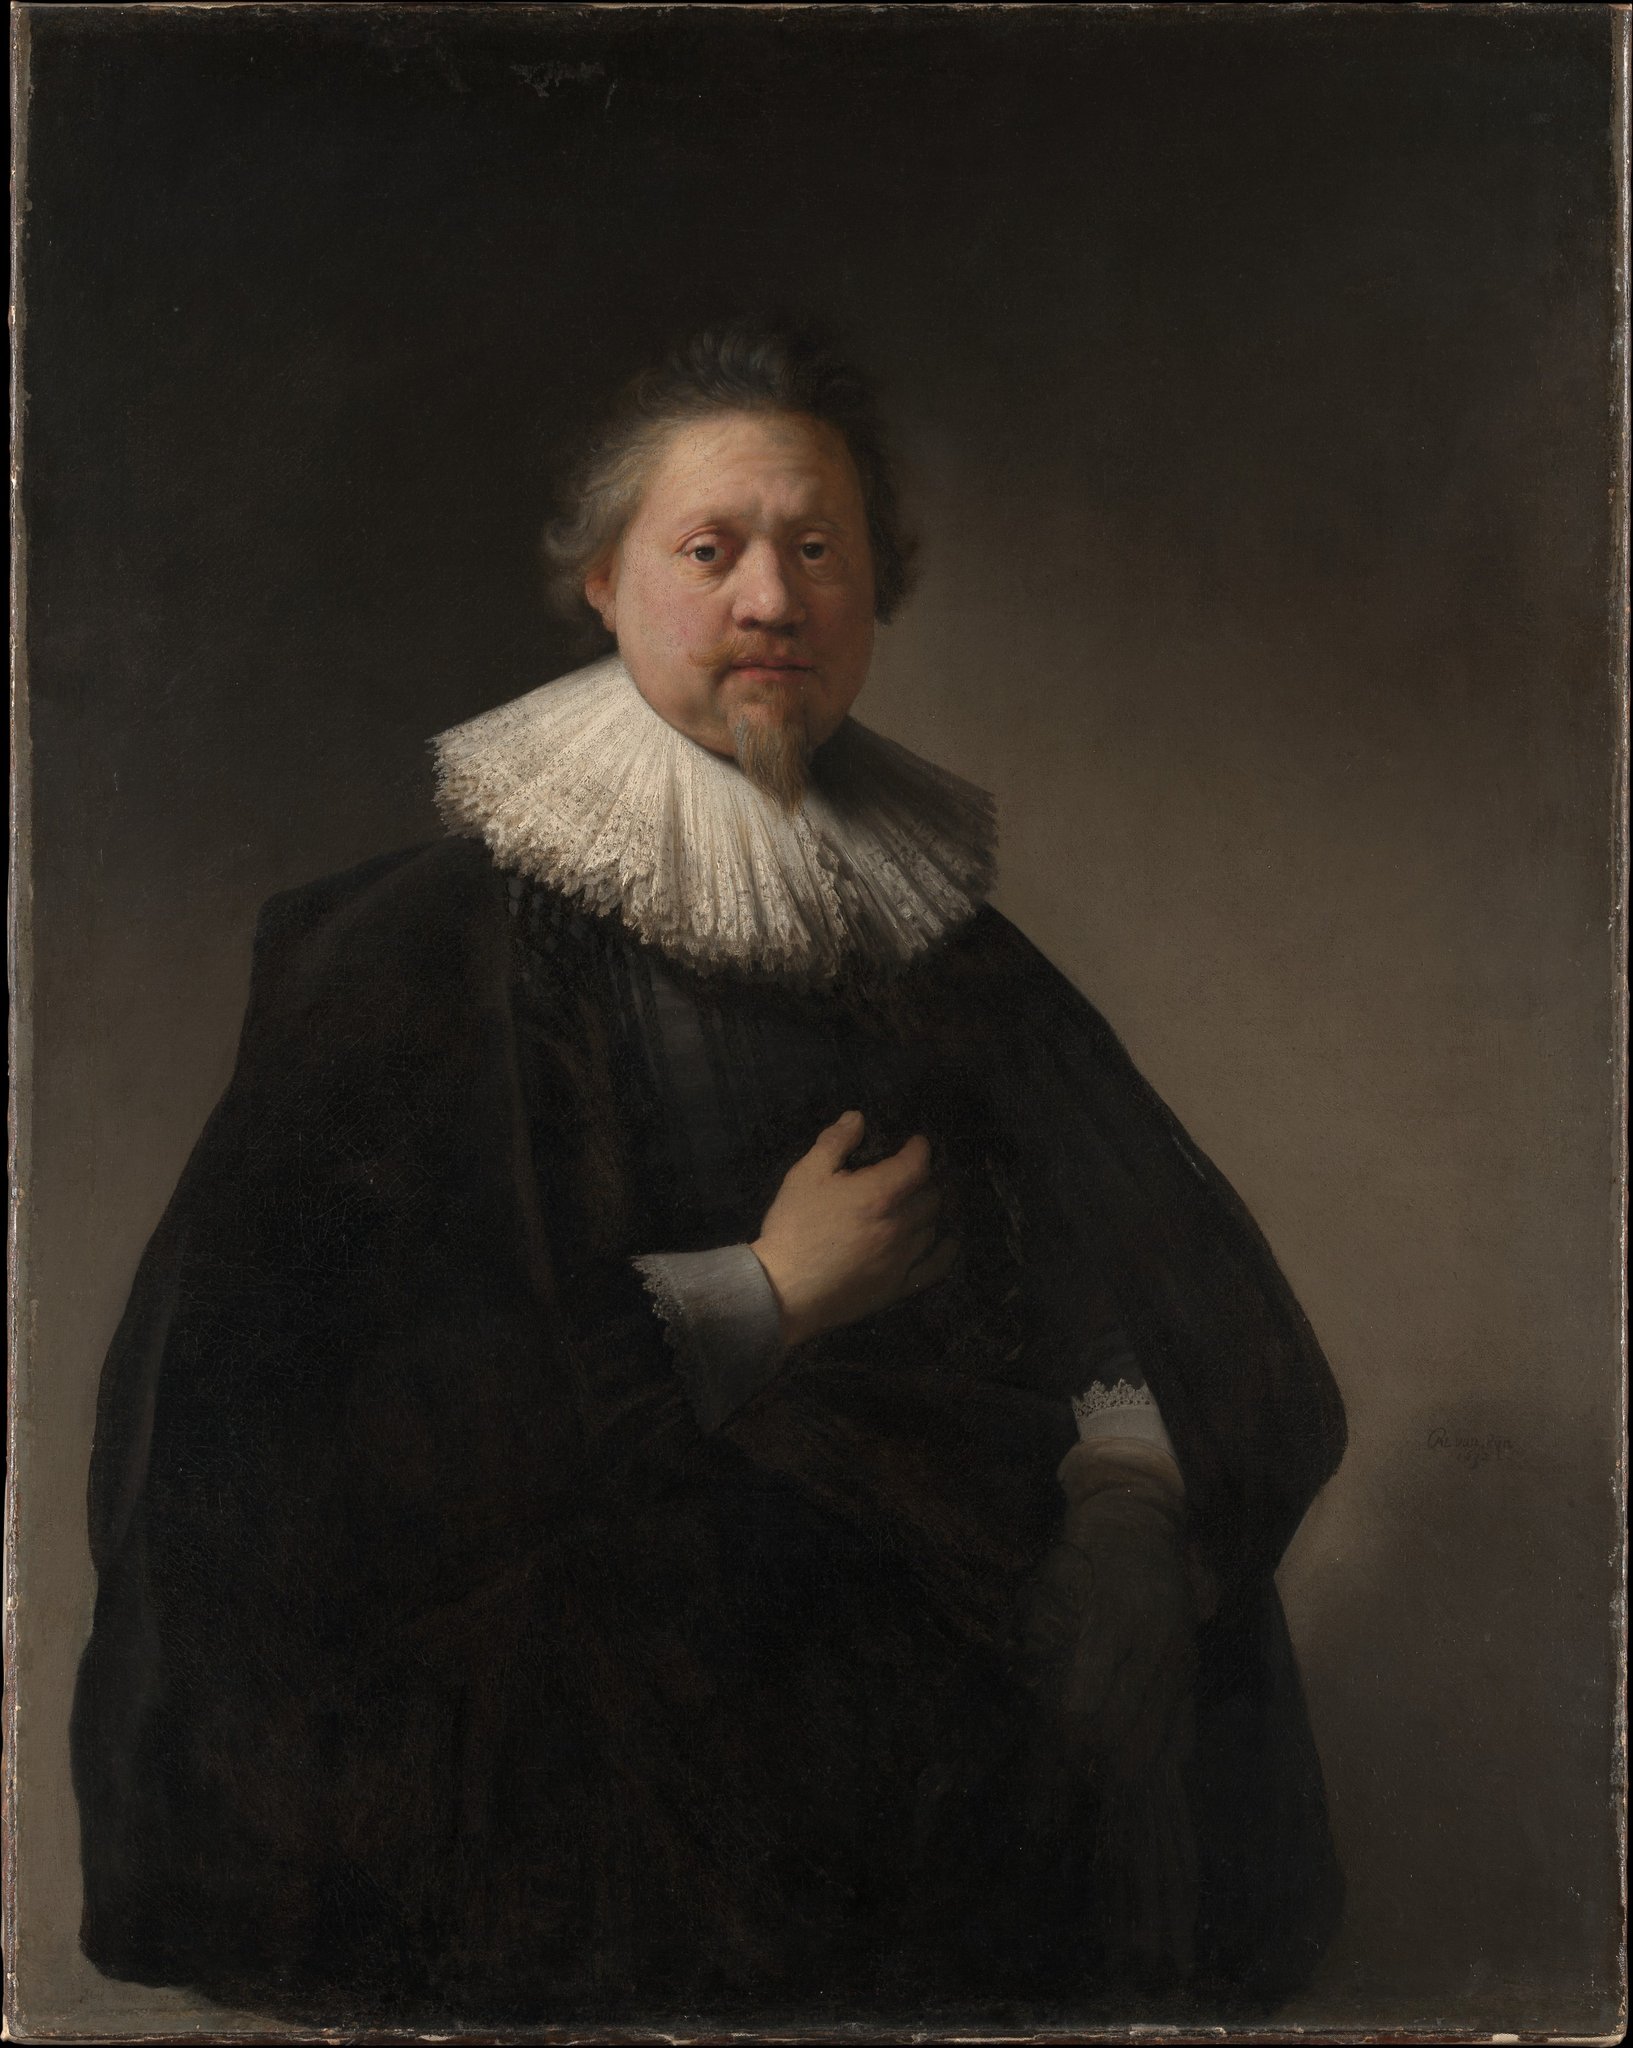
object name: painting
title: Portrait of a Man, probably a Member of the Van Beresteyn Family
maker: rembrandt van rijn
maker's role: artist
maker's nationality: dutch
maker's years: 1606-1669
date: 1632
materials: canvas, oil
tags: men,portraits